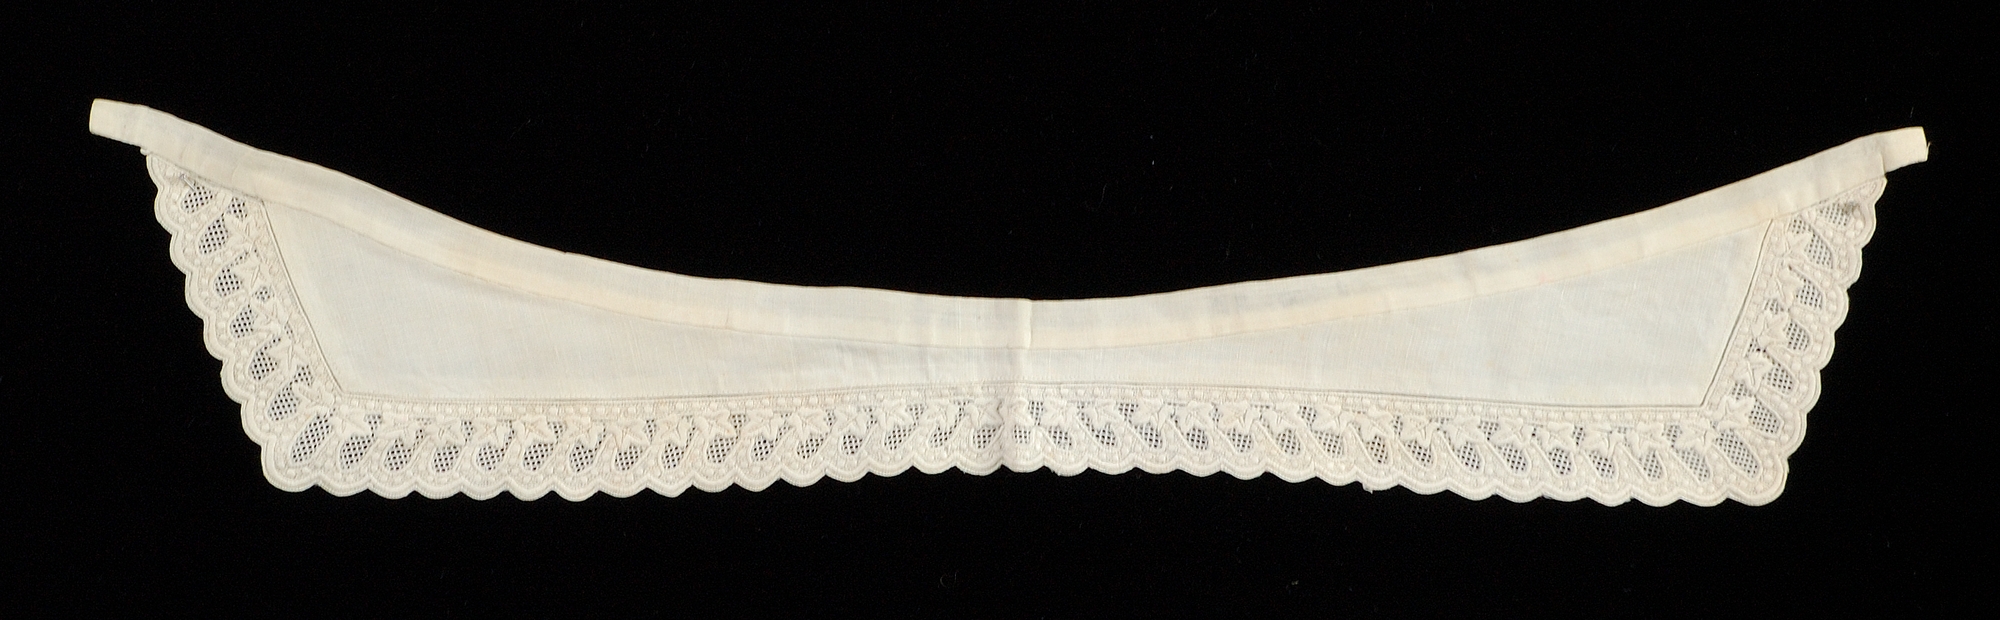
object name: collar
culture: american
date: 1860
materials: linen